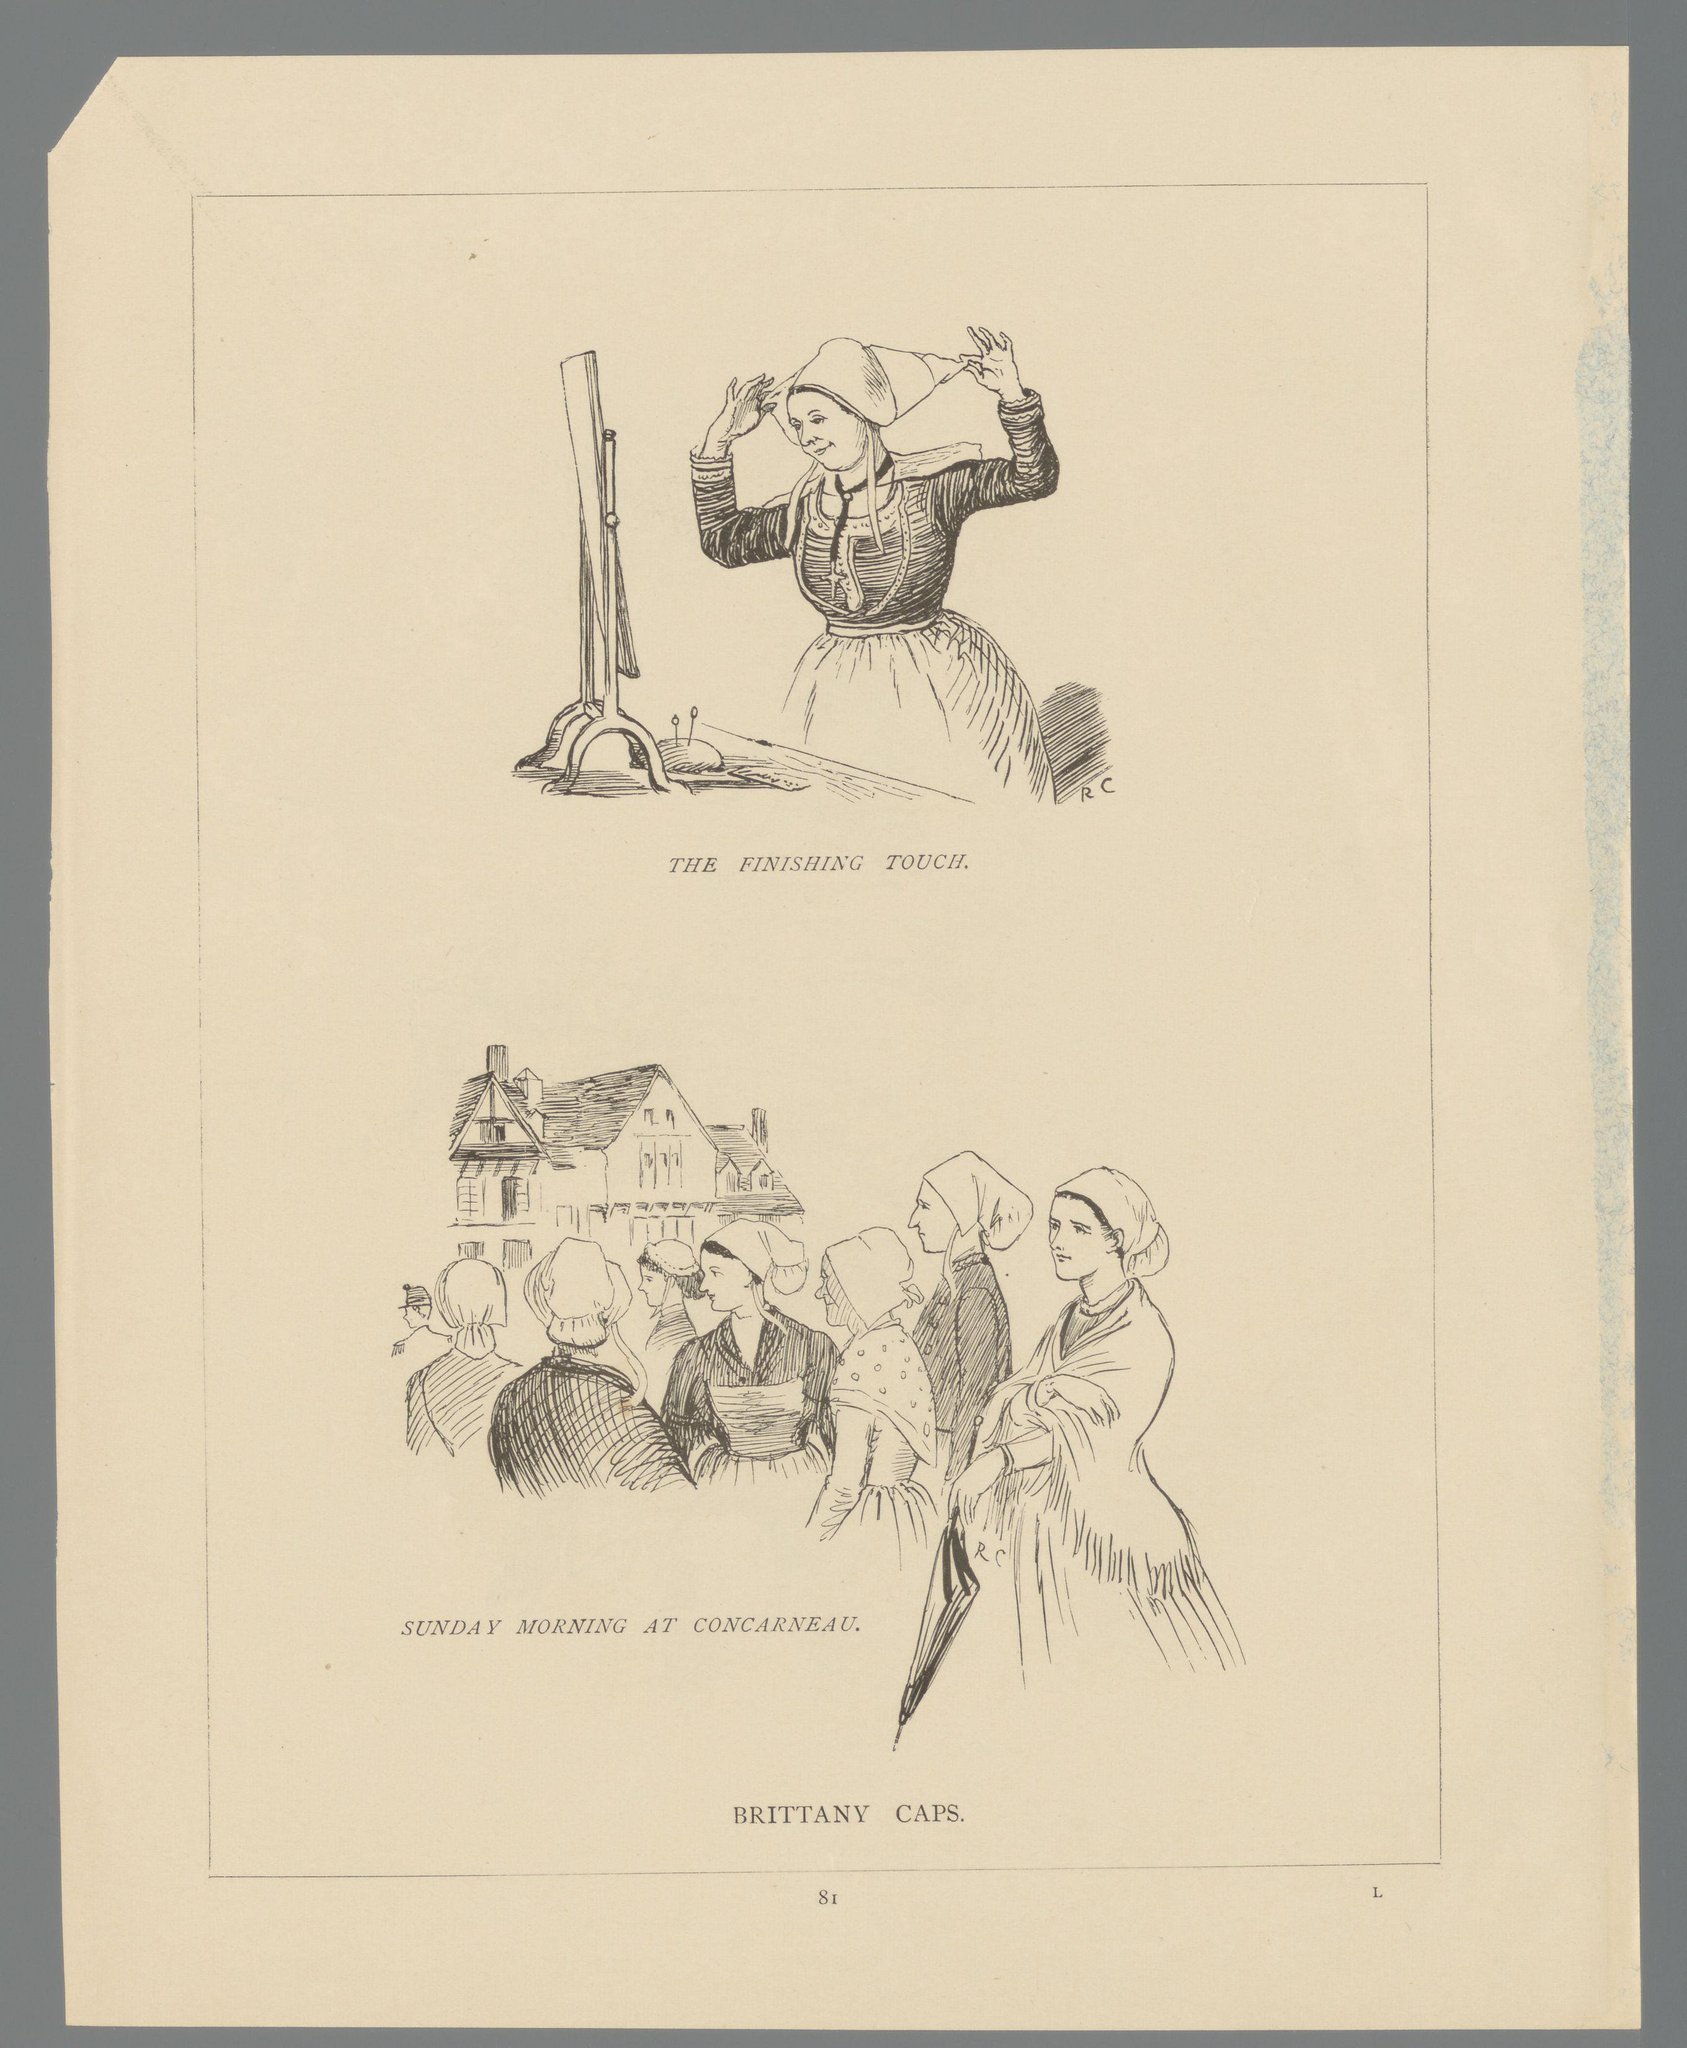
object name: book illustration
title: Zestien illustraties vervaardigd door Randolph Caldecott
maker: randolph caldecott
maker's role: painter, print maker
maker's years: 1846-1886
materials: paper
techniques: letterpress printing, engraving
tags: animals, society, civilization, culture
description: De pagina's lijken allen uit dezelfde onbekende publicatie te komen. Verschillende illustraties zijn gesigneerd met de initialen van Randolph Caldecott: 'RC'. Enkele illustraties zijn gesigneerd met 'Meisenbach'. Mogelijk gaat het om een bundel illustraties van Caldecott die na zijn dood is uitgegeven.